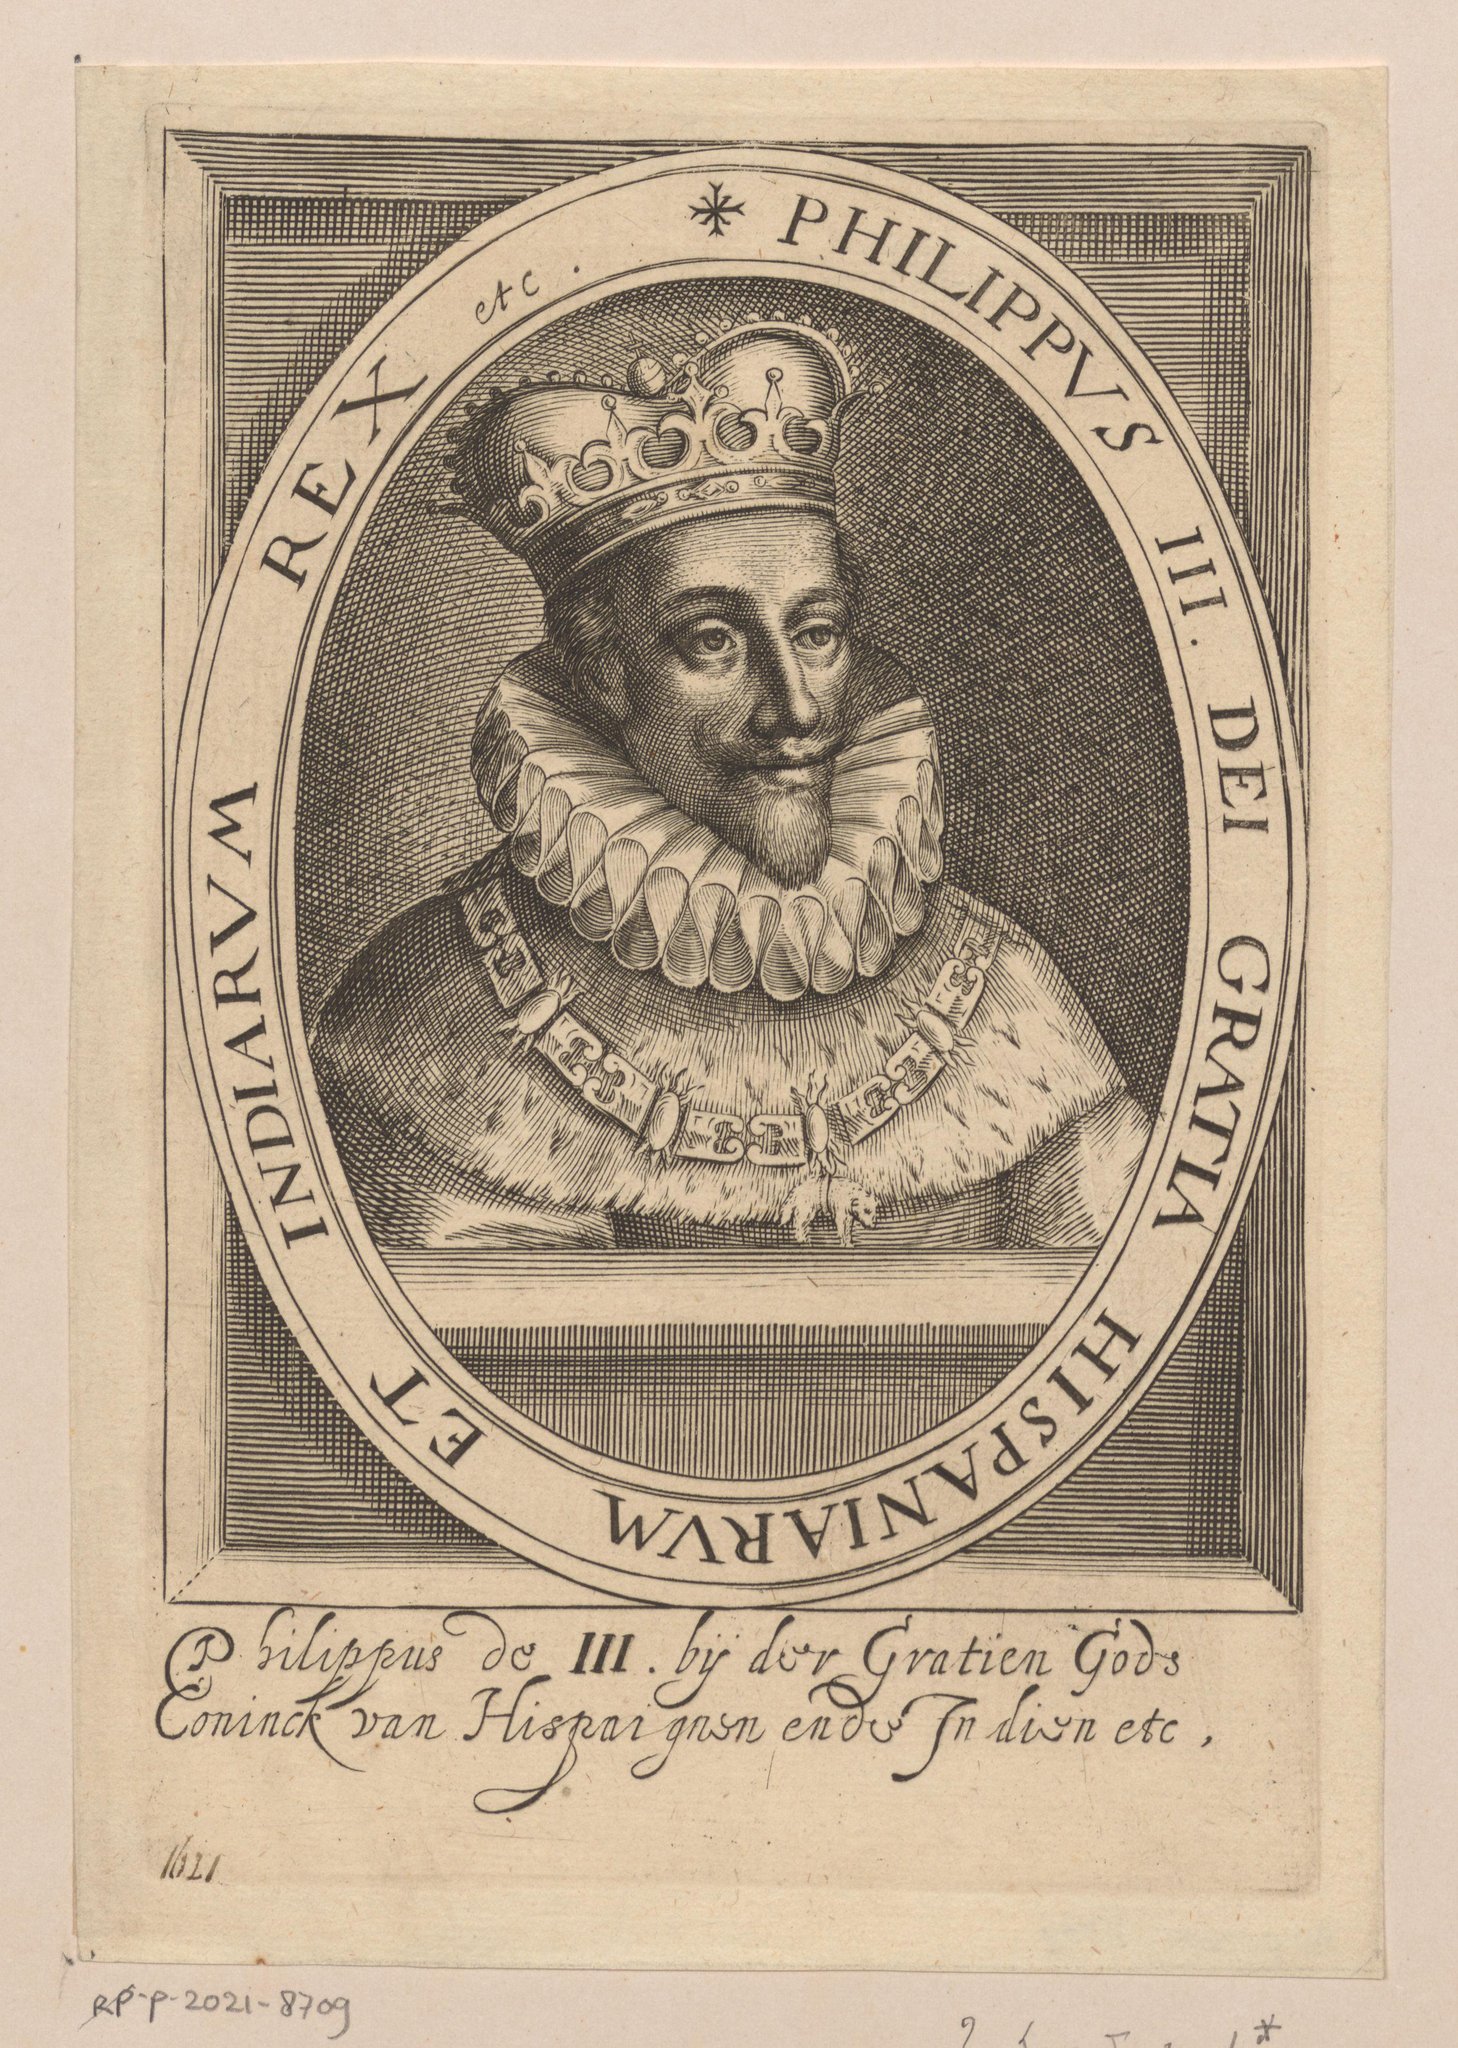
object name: print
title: Portret van Filips III, koning van Spanje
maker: Anonymous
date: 1627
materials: paper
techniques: engraving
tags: filips iii (koning van spanje), historical persons, knighthood order of the golden fleece, insignia and symbols of sovereignty (crown, diadem, sceptre, orb, seal, standard, cloak, pectoral)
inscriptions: inscription: ‘1621’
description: Prent mogelijk uit: Meteren, Emmanuel van. Eygentliche und vollkommene Historische Beschreibung deß Niderländischen Kriegs. Amsterdam: Johannes Jansonius, 1627.